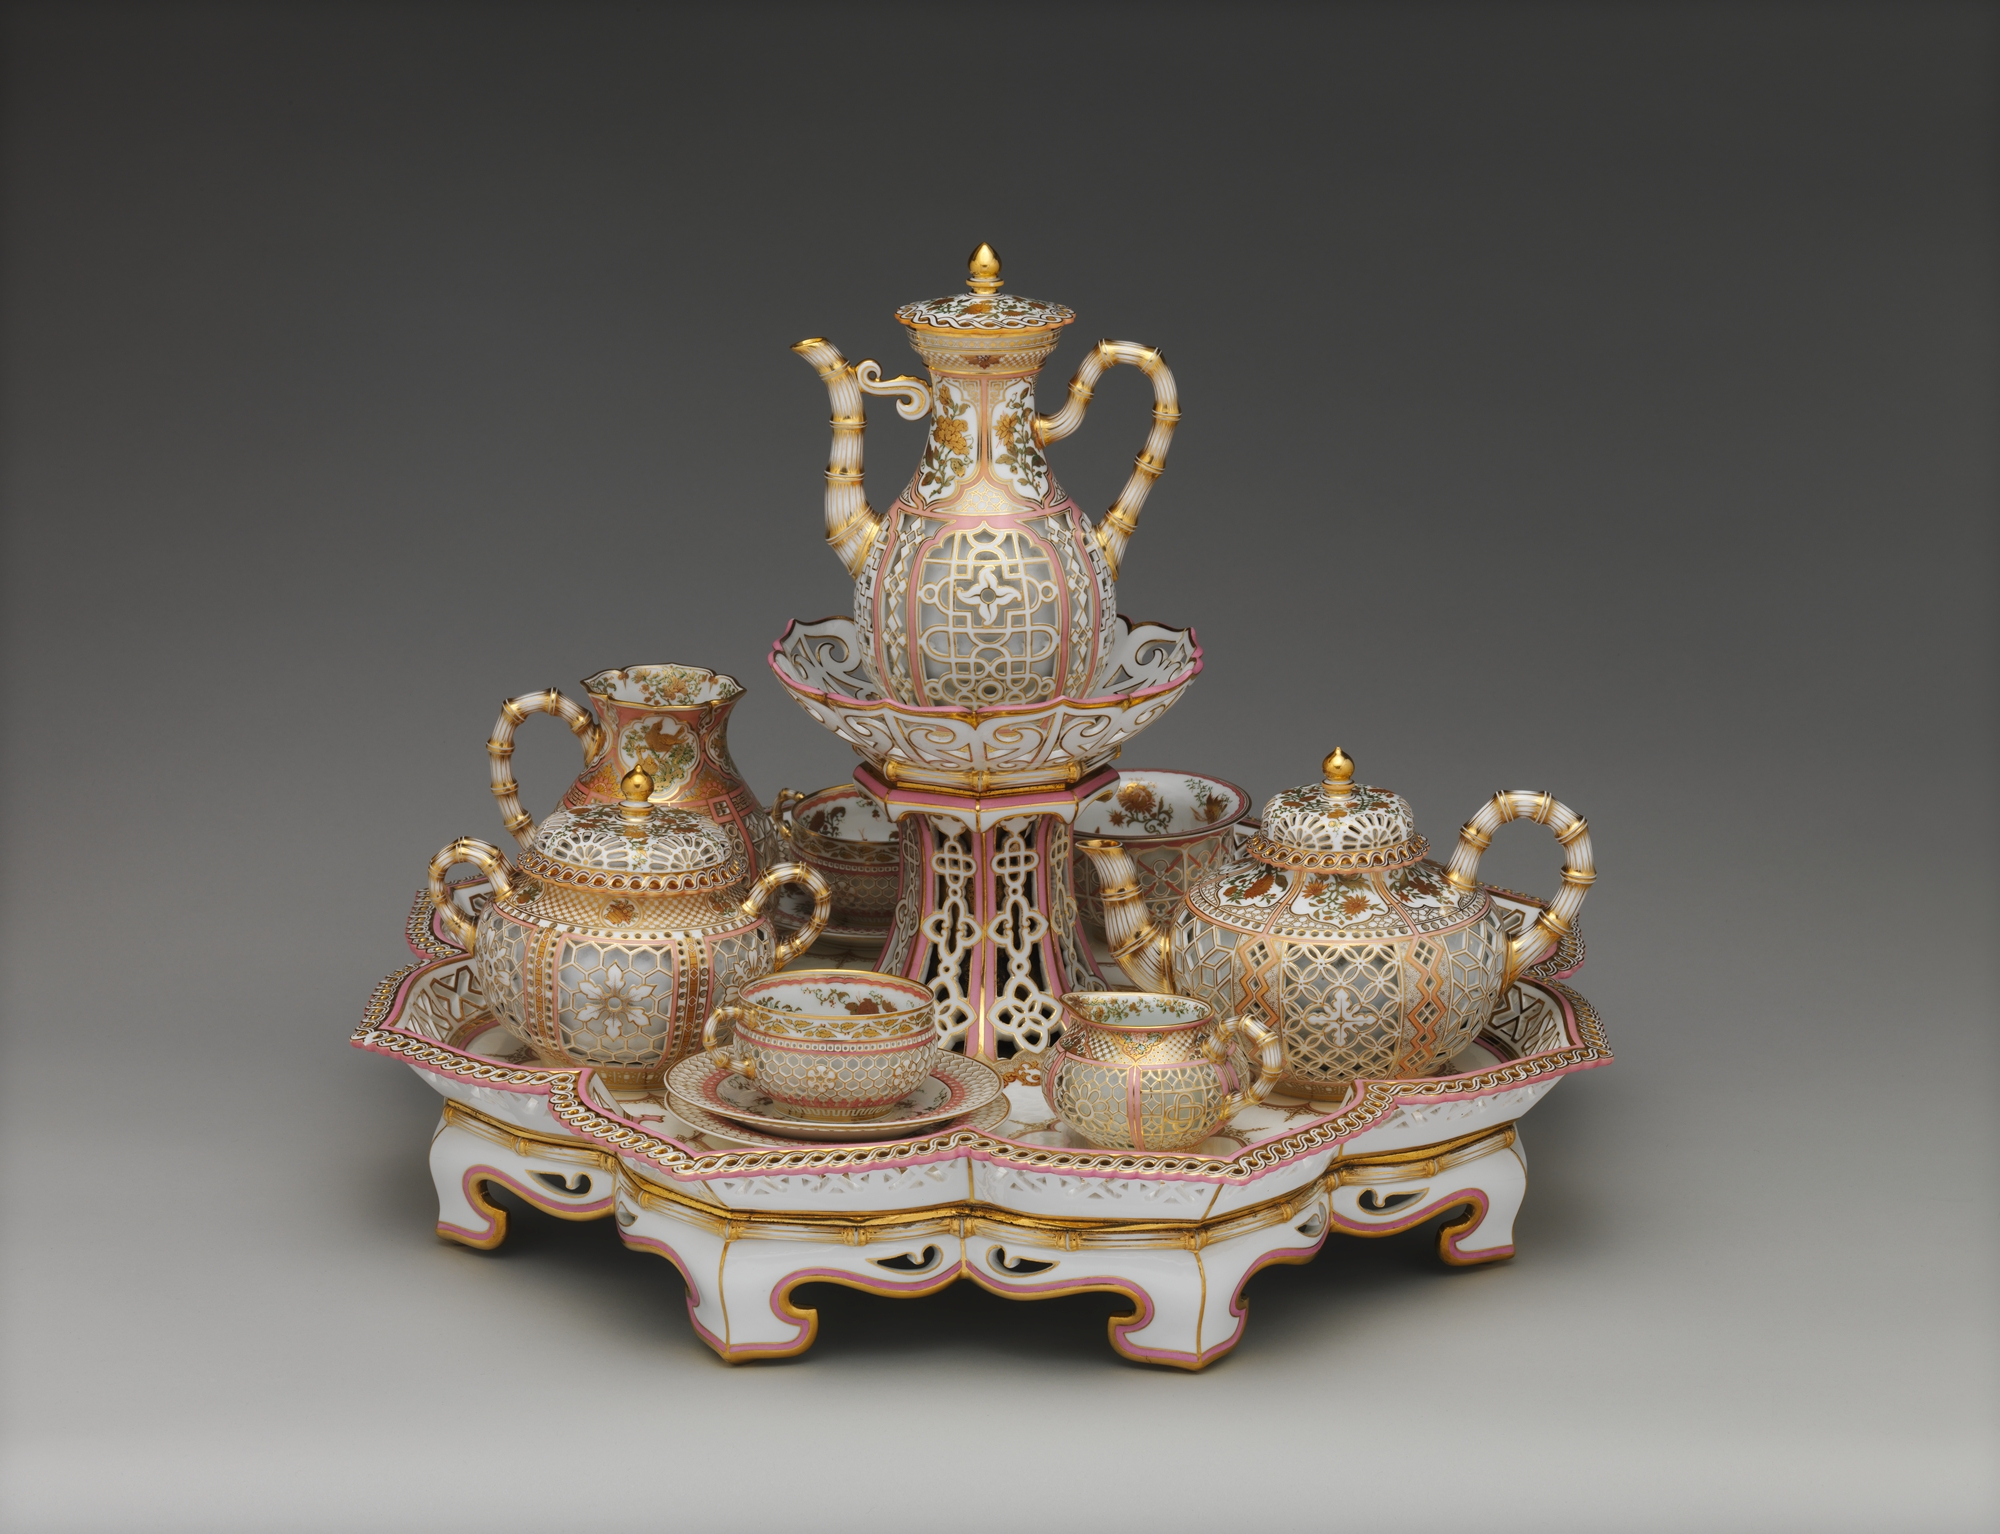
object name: tea and coffee service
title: Coffee and tea service (déjeuner chinois réticulé)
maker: sèvres manufactory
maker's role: manufactory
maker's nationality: french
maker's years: 1740-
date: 1855-1861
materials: hard paste porcelain